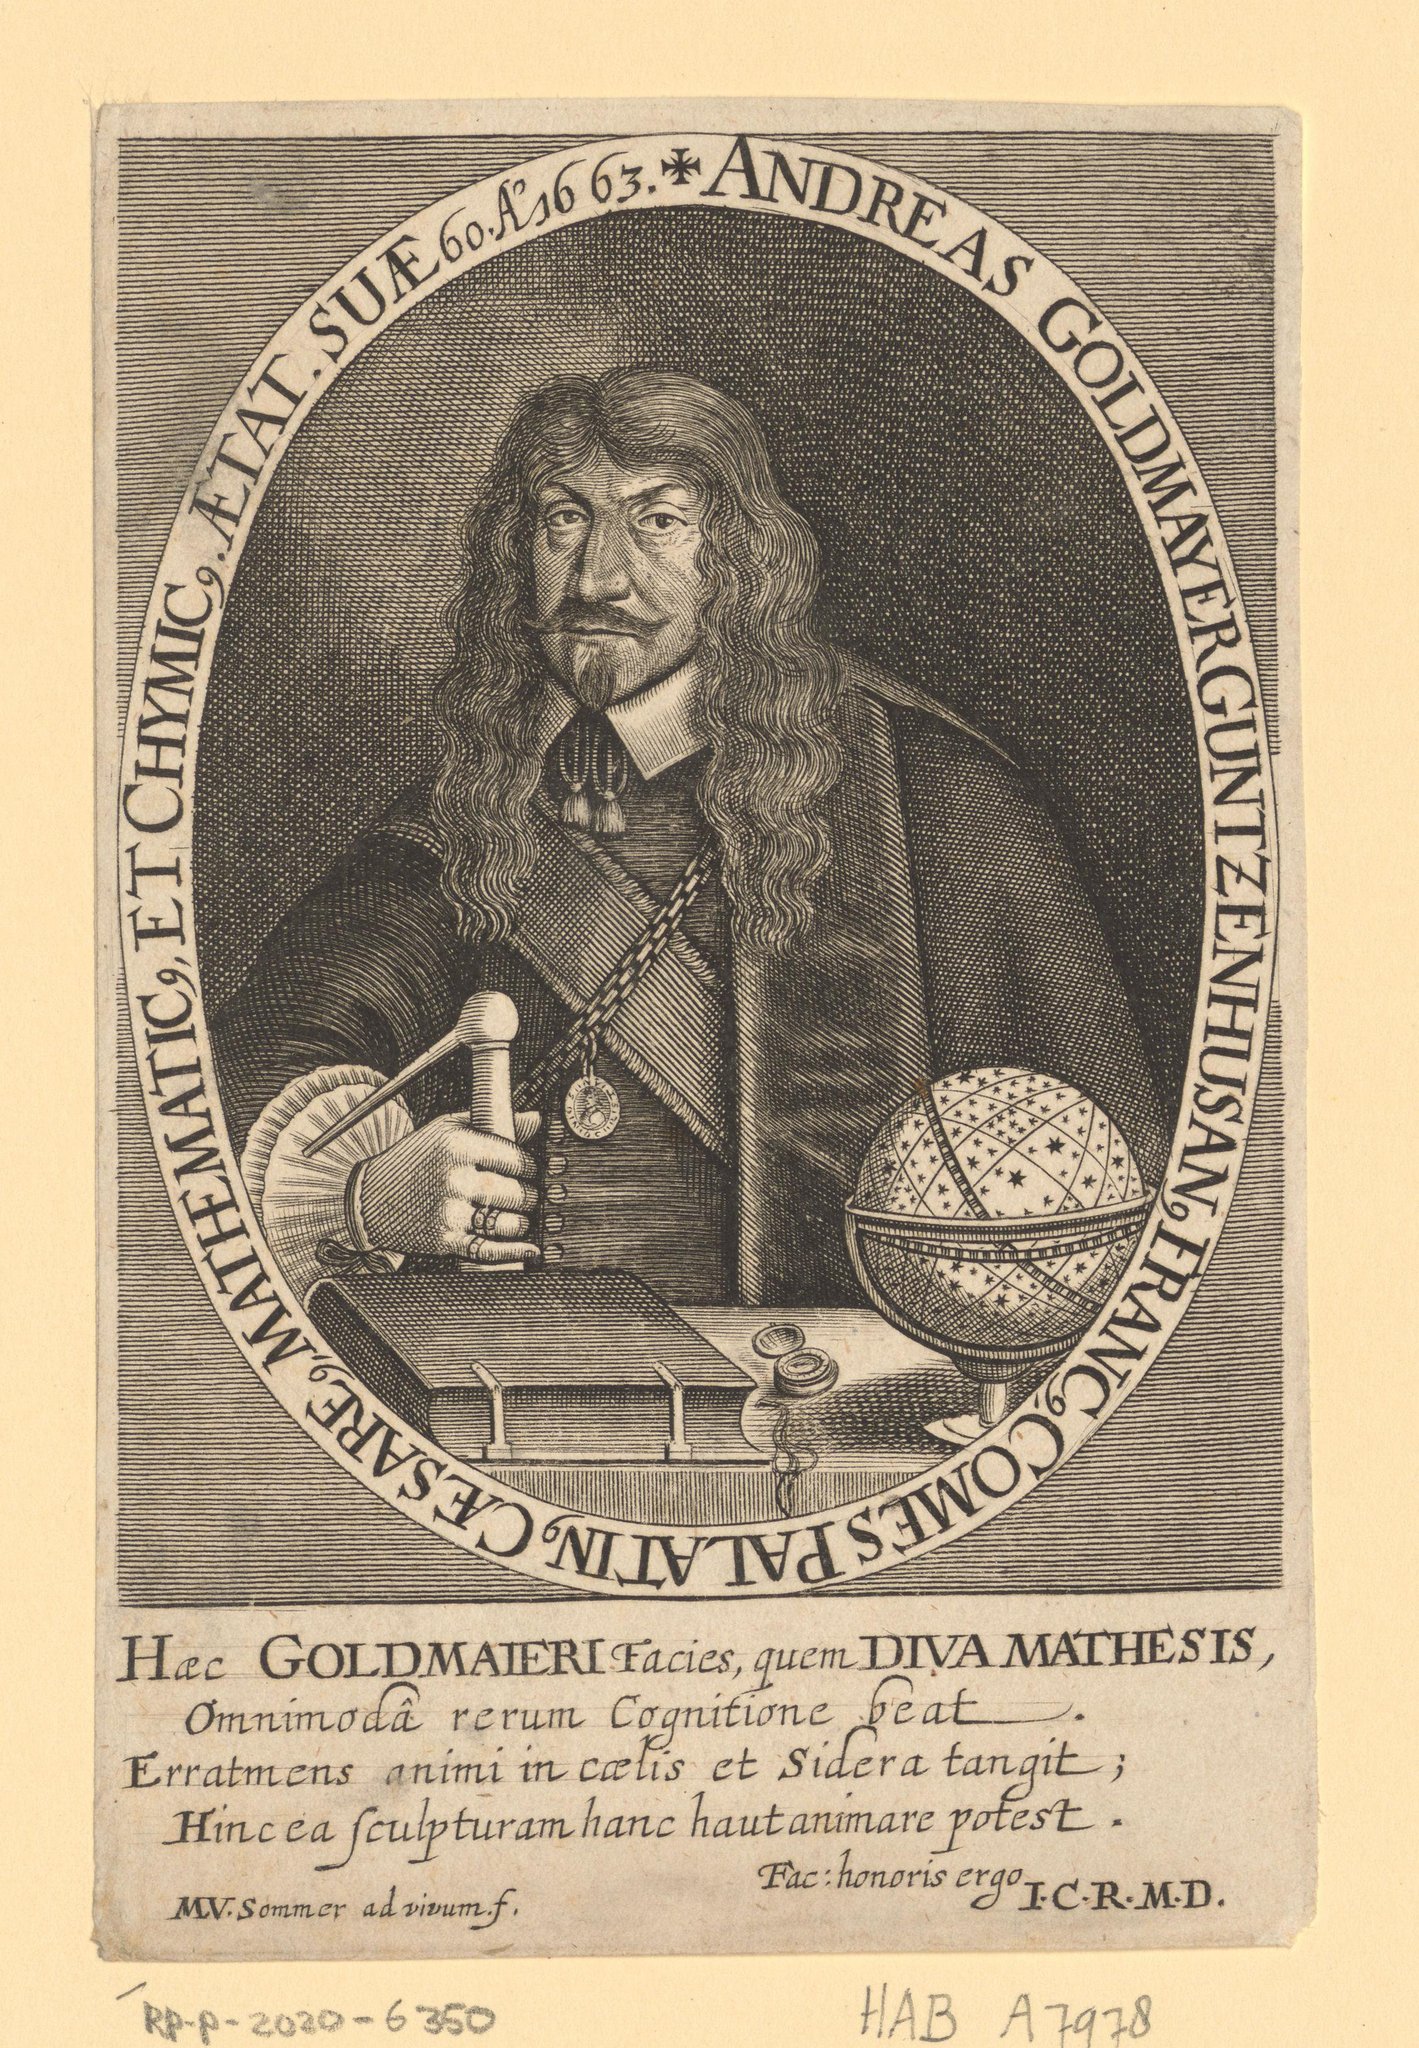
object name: print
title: Portret van Andreas Goldmayer op 60-jarige leeftijd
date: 1663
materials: paper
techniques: engraving, etching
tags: historical persons, physician, doctor (+ portrait of scholar, scientist), mathematics (+ portrait of scholar, scientist)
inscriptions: date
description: Tekst in het Latijn in de ondermarge en in de omlijsting.